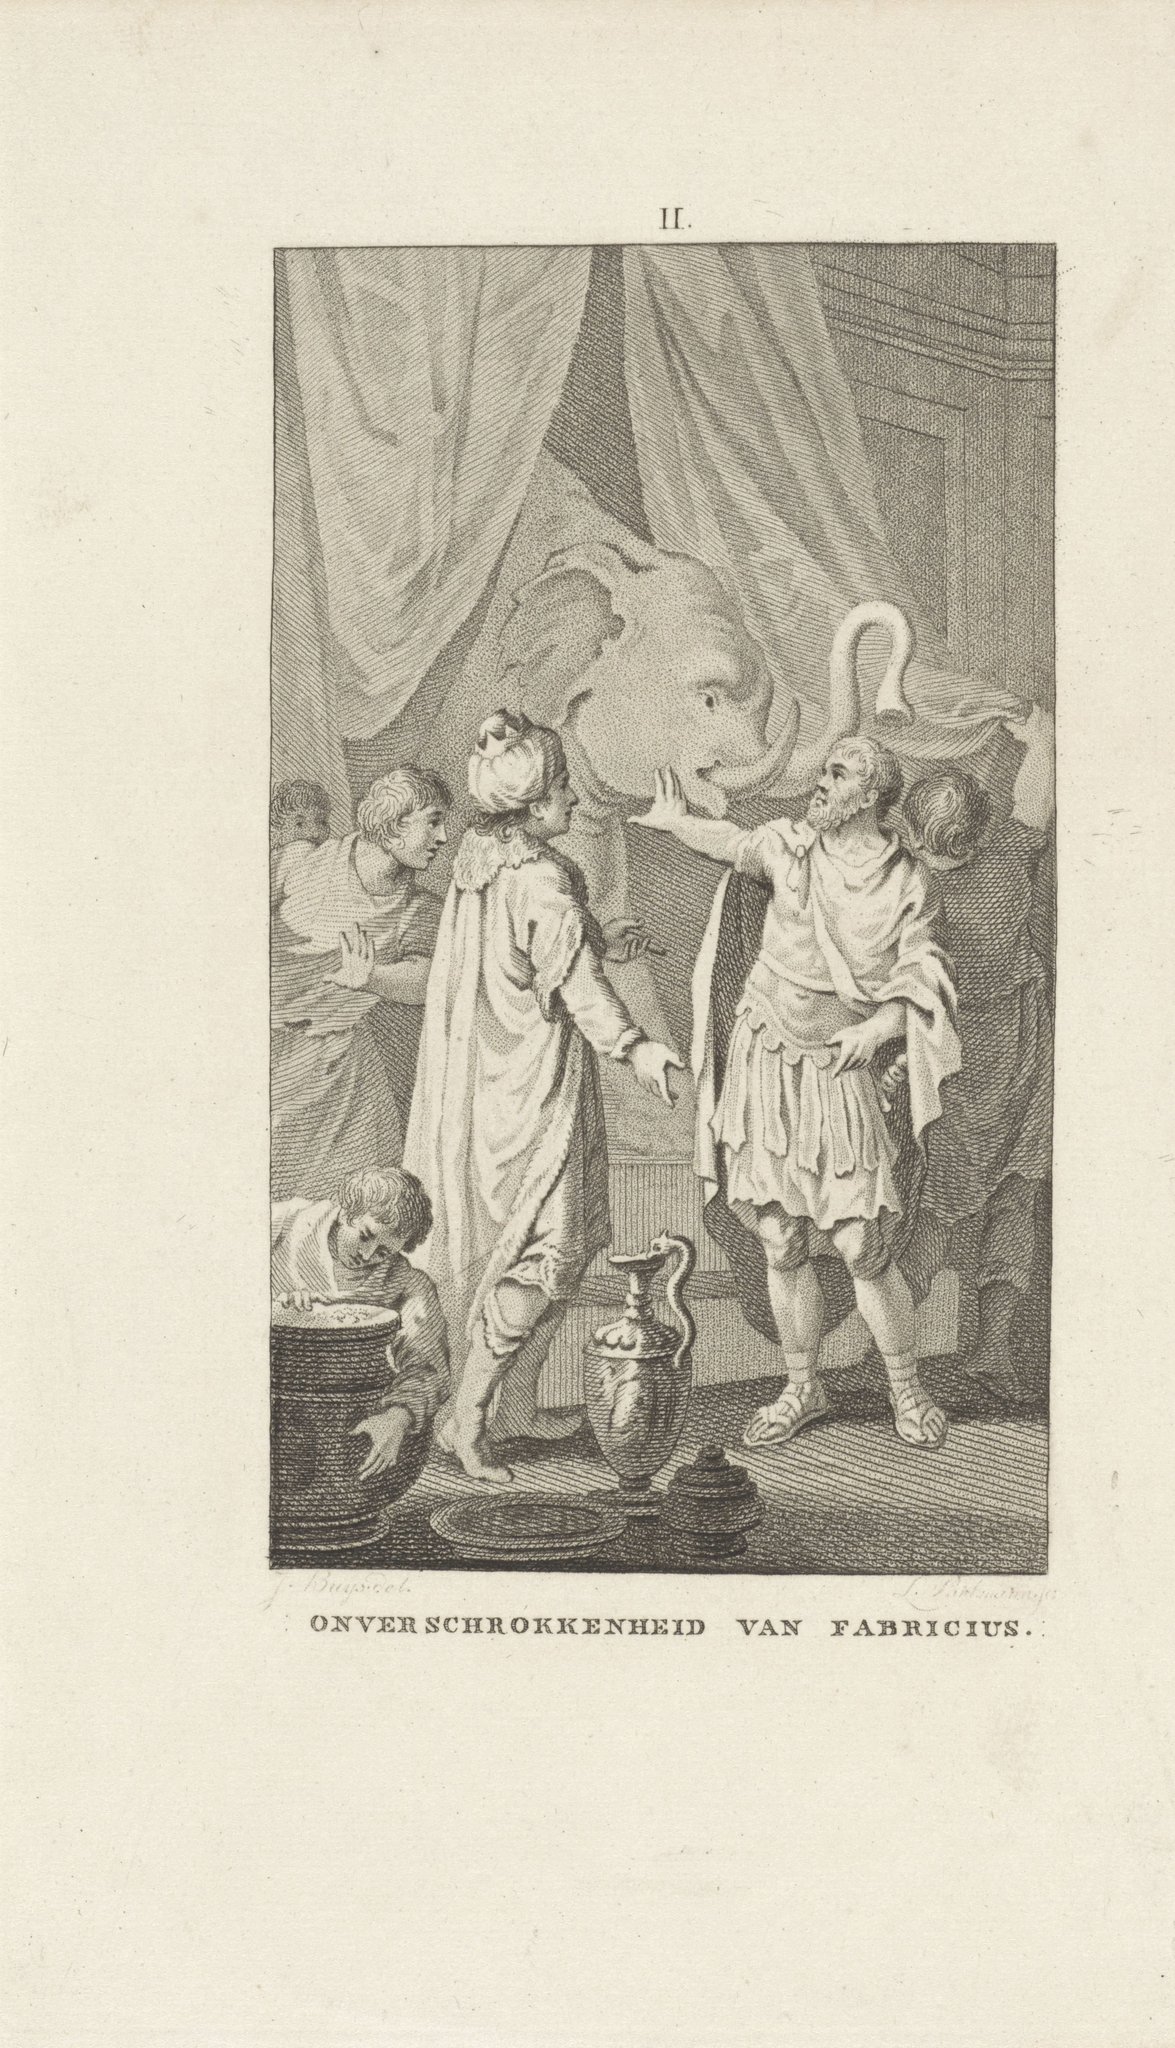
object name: book illustration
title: Onverschrokkenheid van Fabricius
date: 1794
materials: paper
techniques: stippled etching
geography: amsterdam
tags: c. fabricius refuses the gifts of pyrrhus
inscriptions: collector's mark: Lugt 2228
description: Koning Pyrrhus probeert Gaius Fabricius om te kopen met geschenken. Hij biedt hem uiteindelijk zelfs een olifant aan.